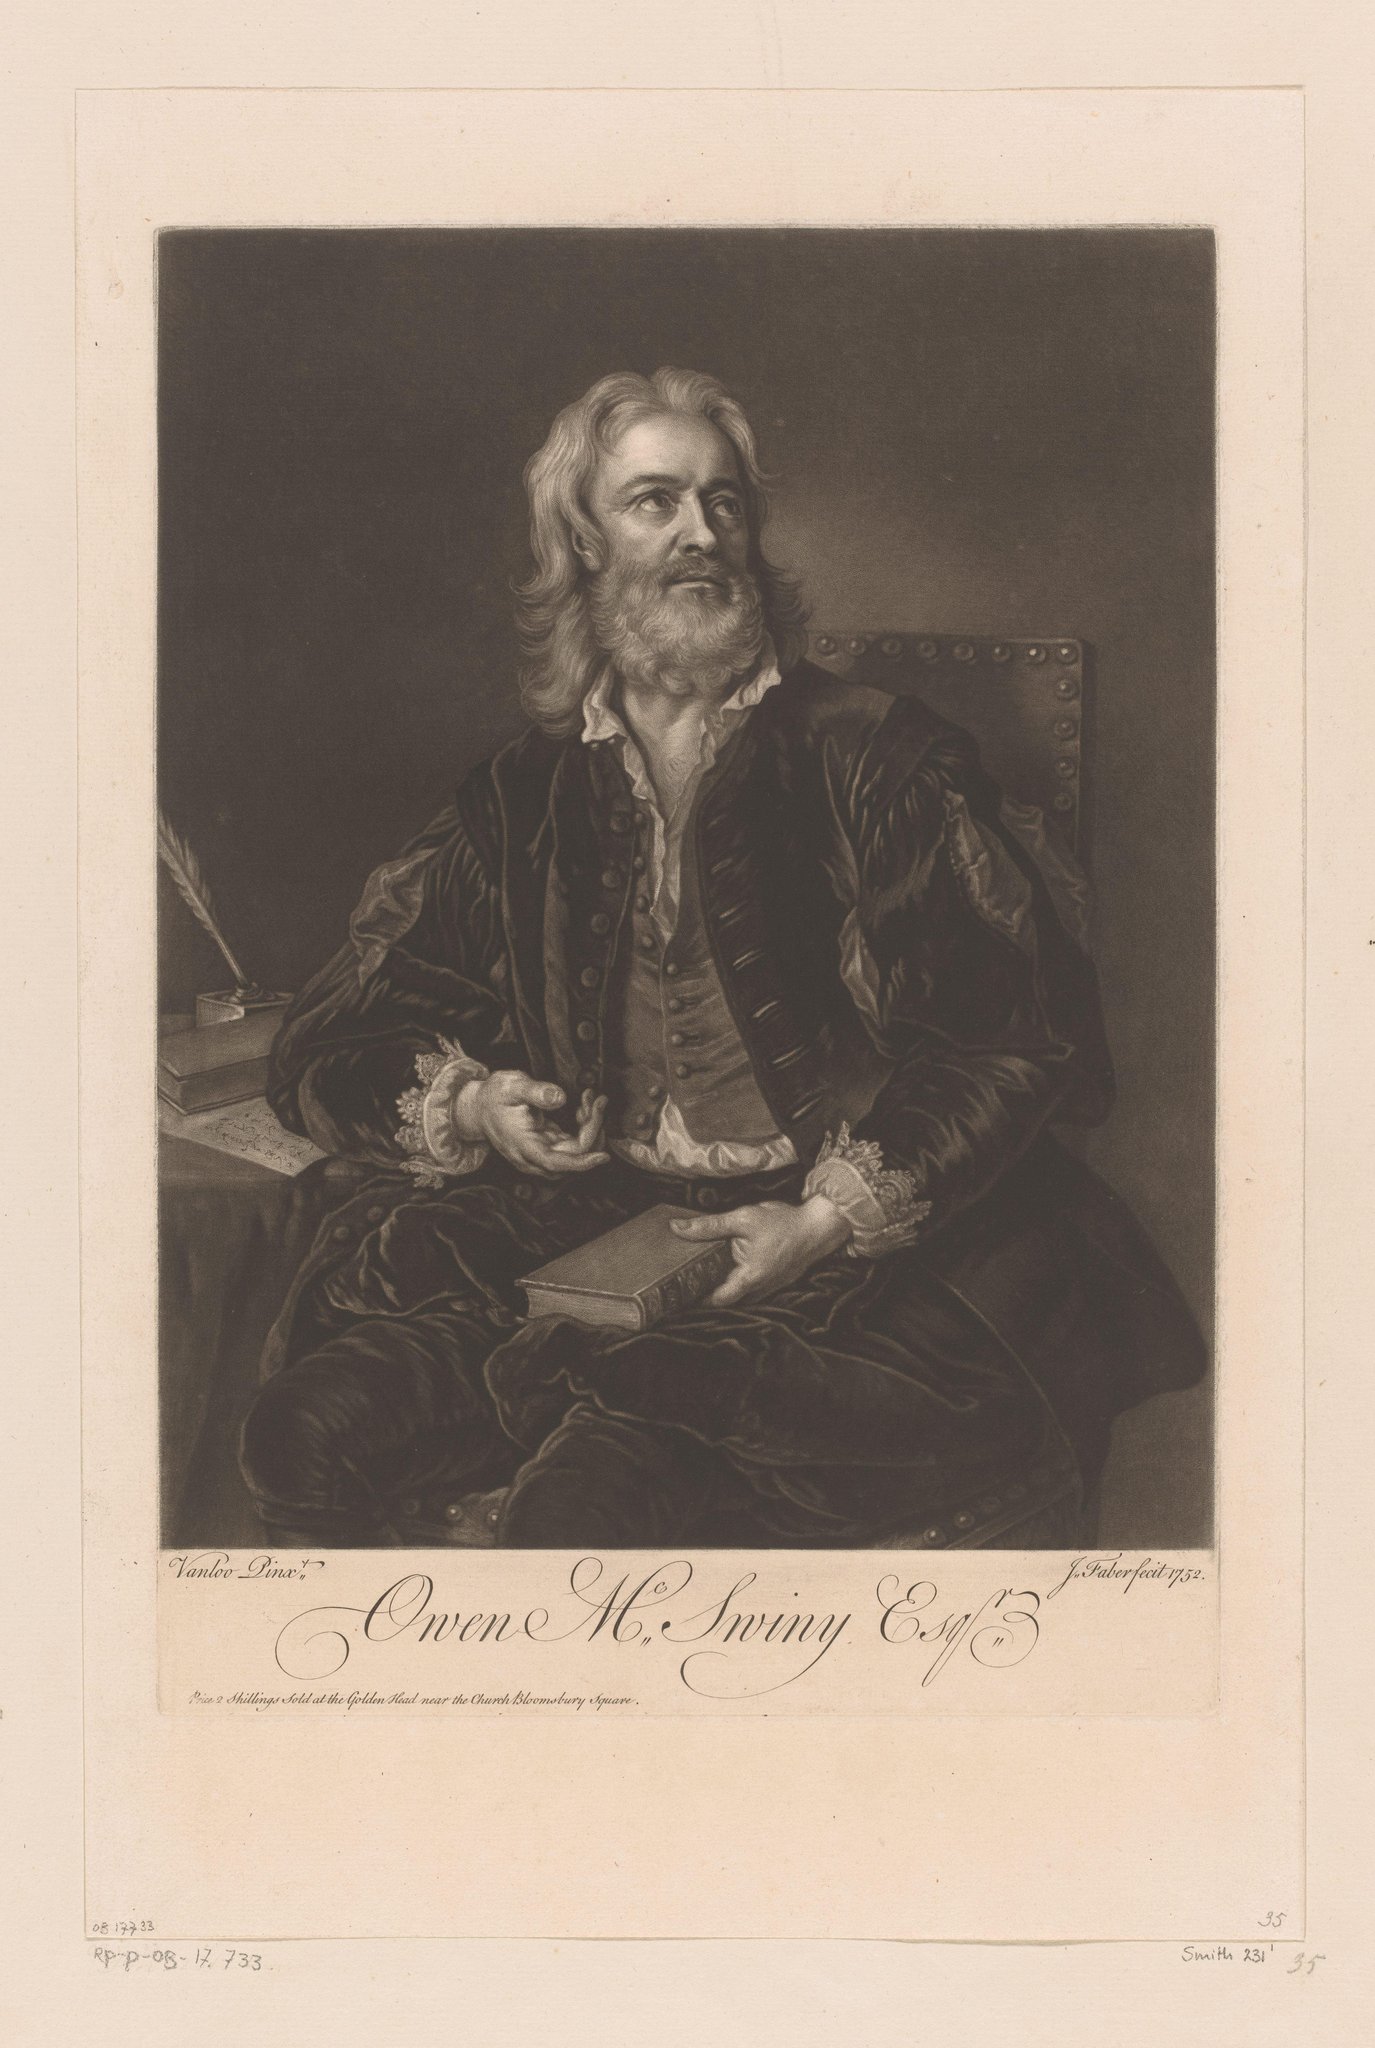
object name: print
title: Portret van Owen MacSwiney Esqr.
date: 1752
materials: paper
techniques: etching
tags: director, producer ~ the stage, historical persons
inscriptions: collector's mark: Lugt 240